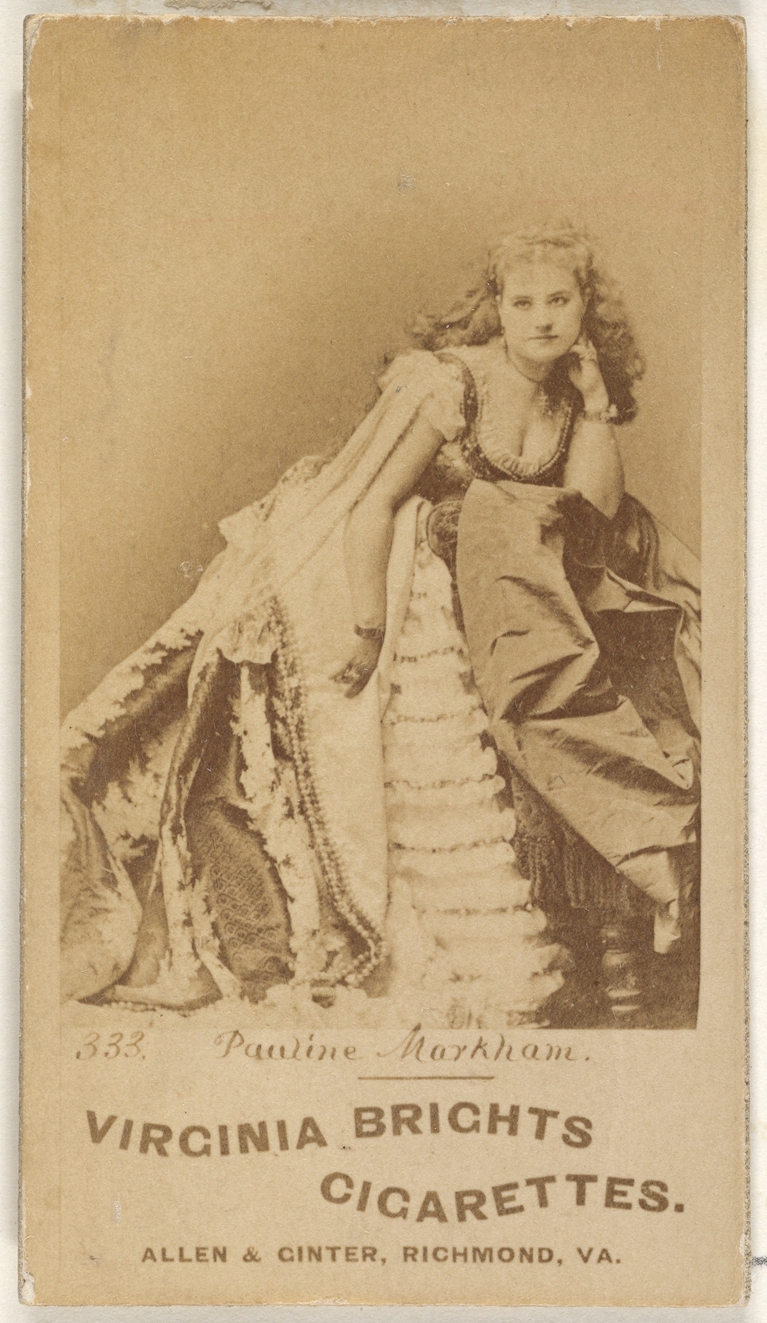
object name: photograph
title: Card 333, Pauline Markham, from the Actors and Actresses series (N45, Type 1) for Virginia Brights Cigarettes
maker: allen & ginter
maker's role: publisher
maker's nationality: american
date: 1888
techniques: albumen silver print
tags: portraits,women,actresses